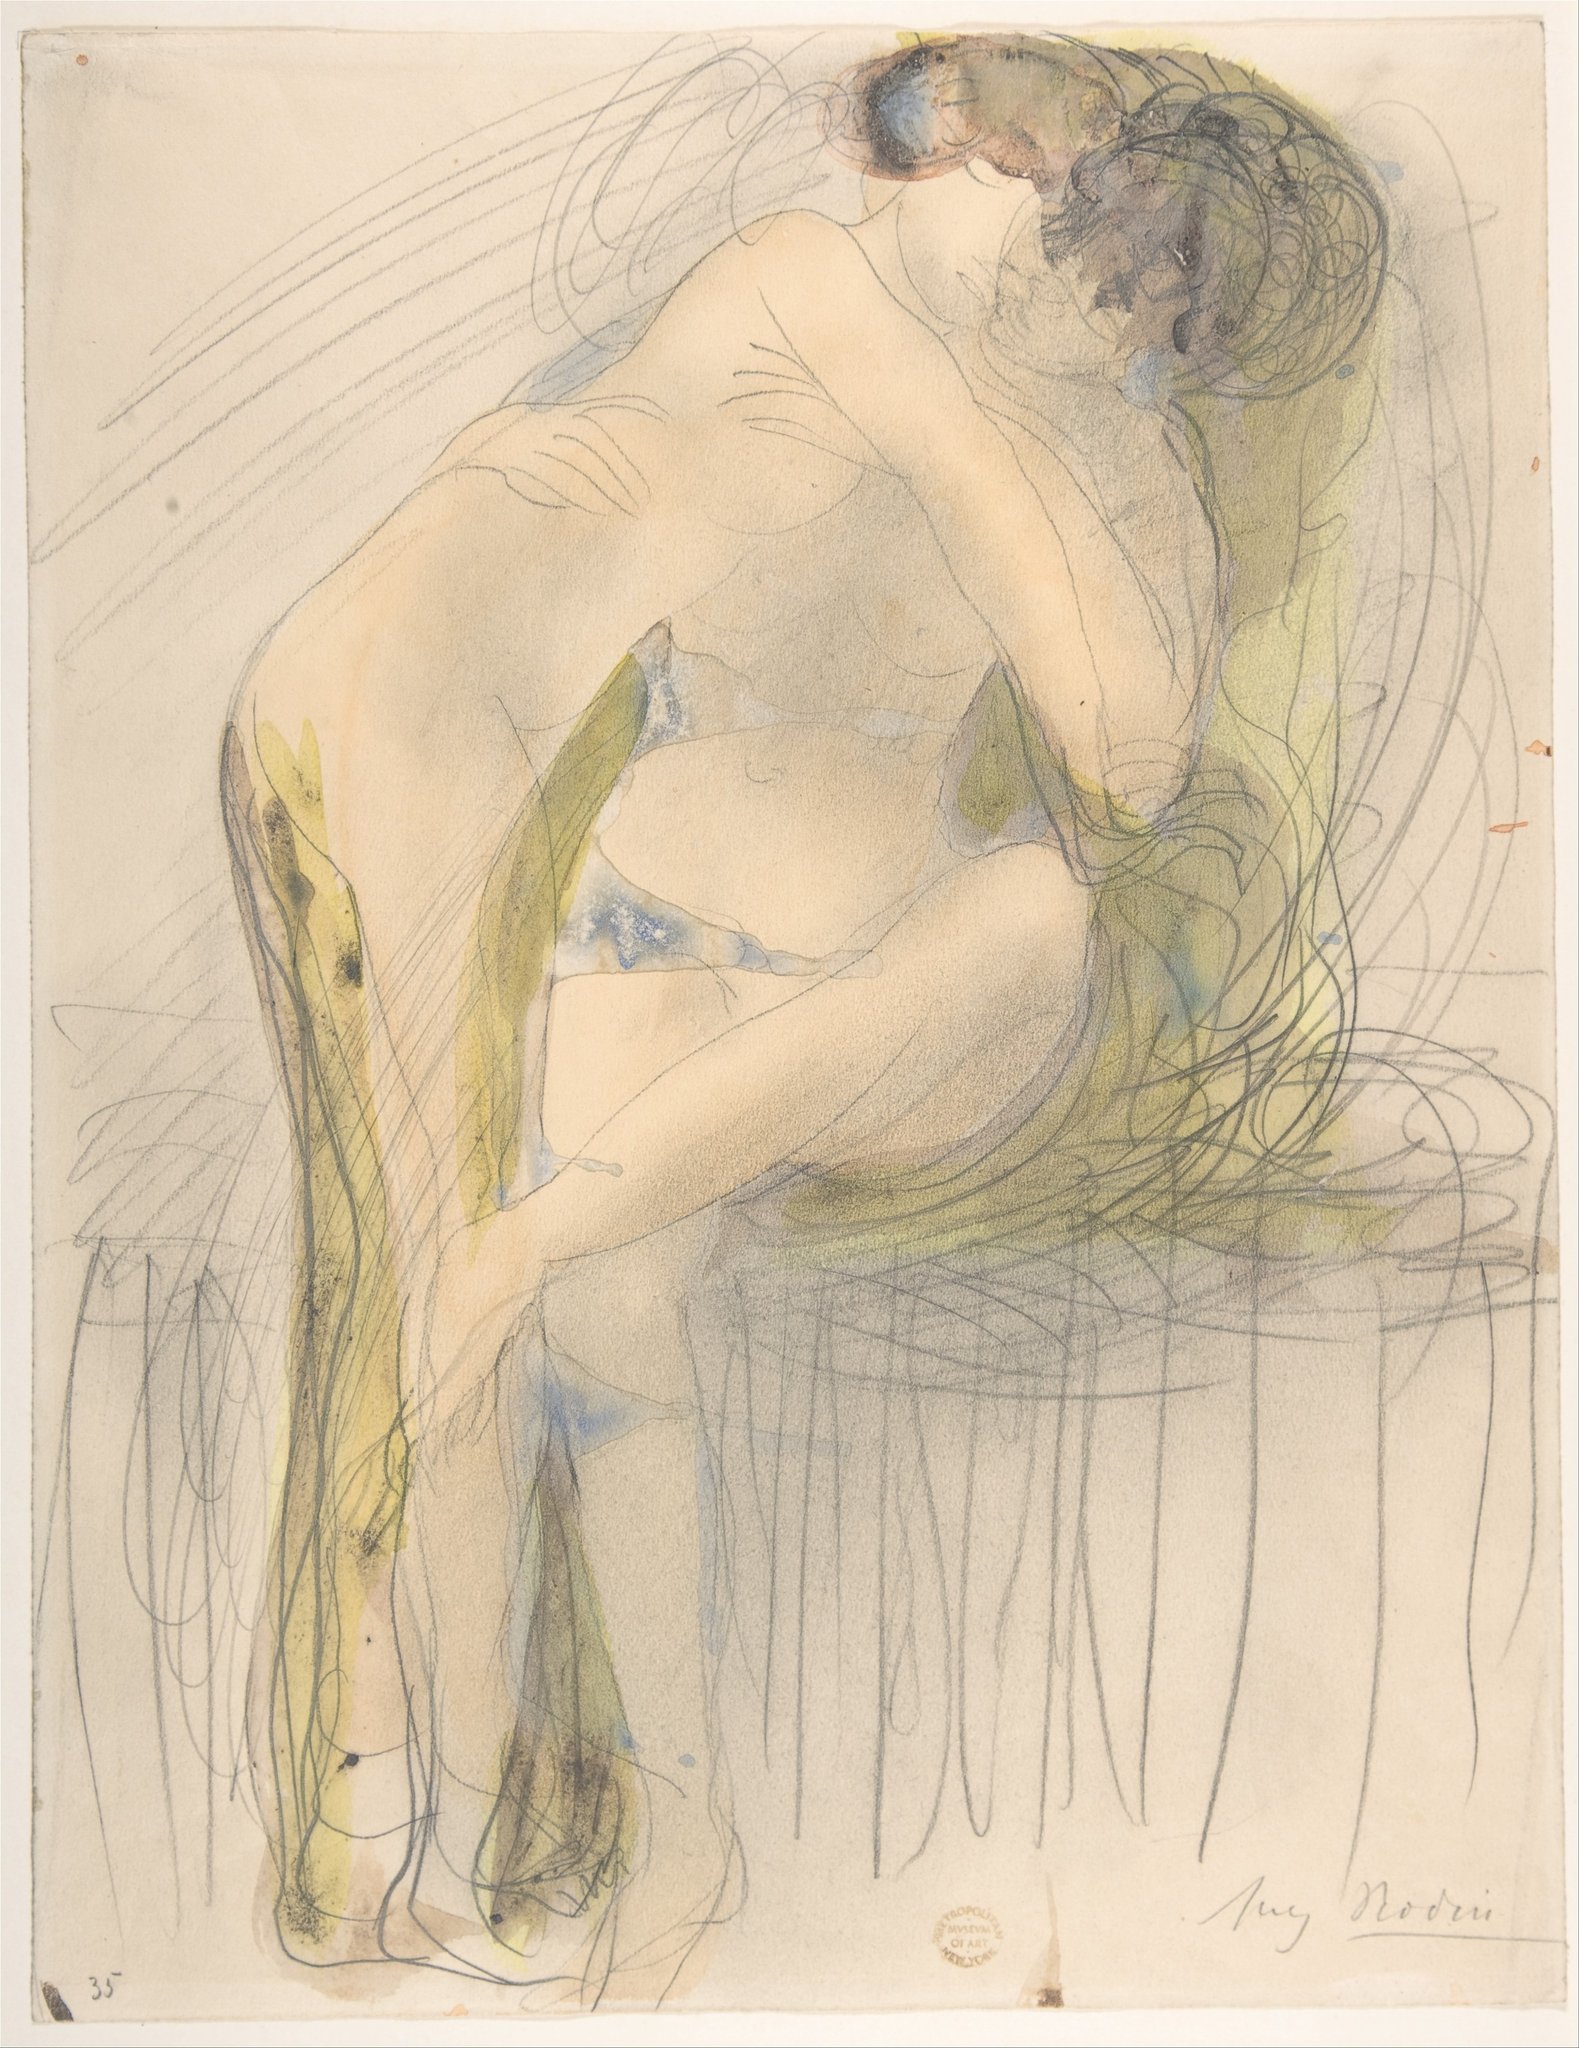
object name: drawing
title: The Embrace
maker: auguste rodin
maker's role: artist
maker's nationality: french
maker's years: 1840-1917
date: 1900-1910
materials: gouache, graphite, watercolor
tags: couples,male nudes,lovers,female nudes